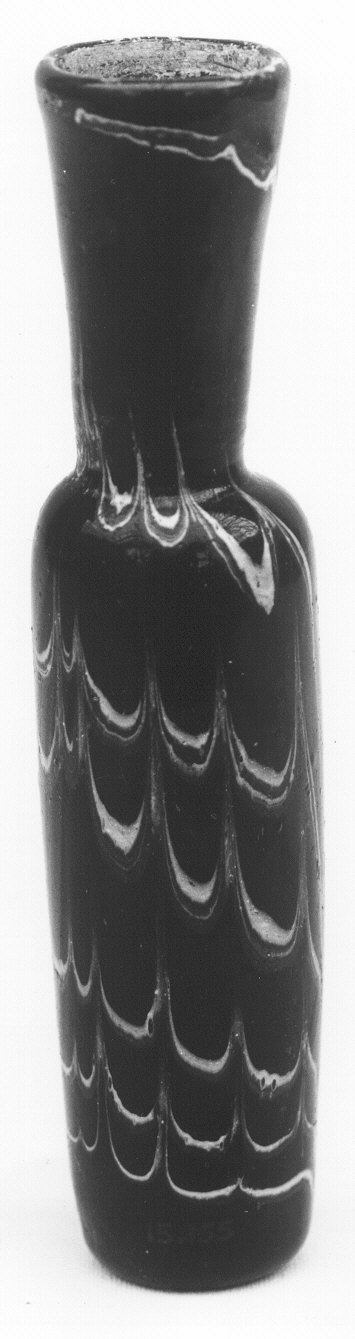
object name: flask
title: Small Bottle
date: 1201-1300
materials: glass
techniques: glassblowing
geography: syria